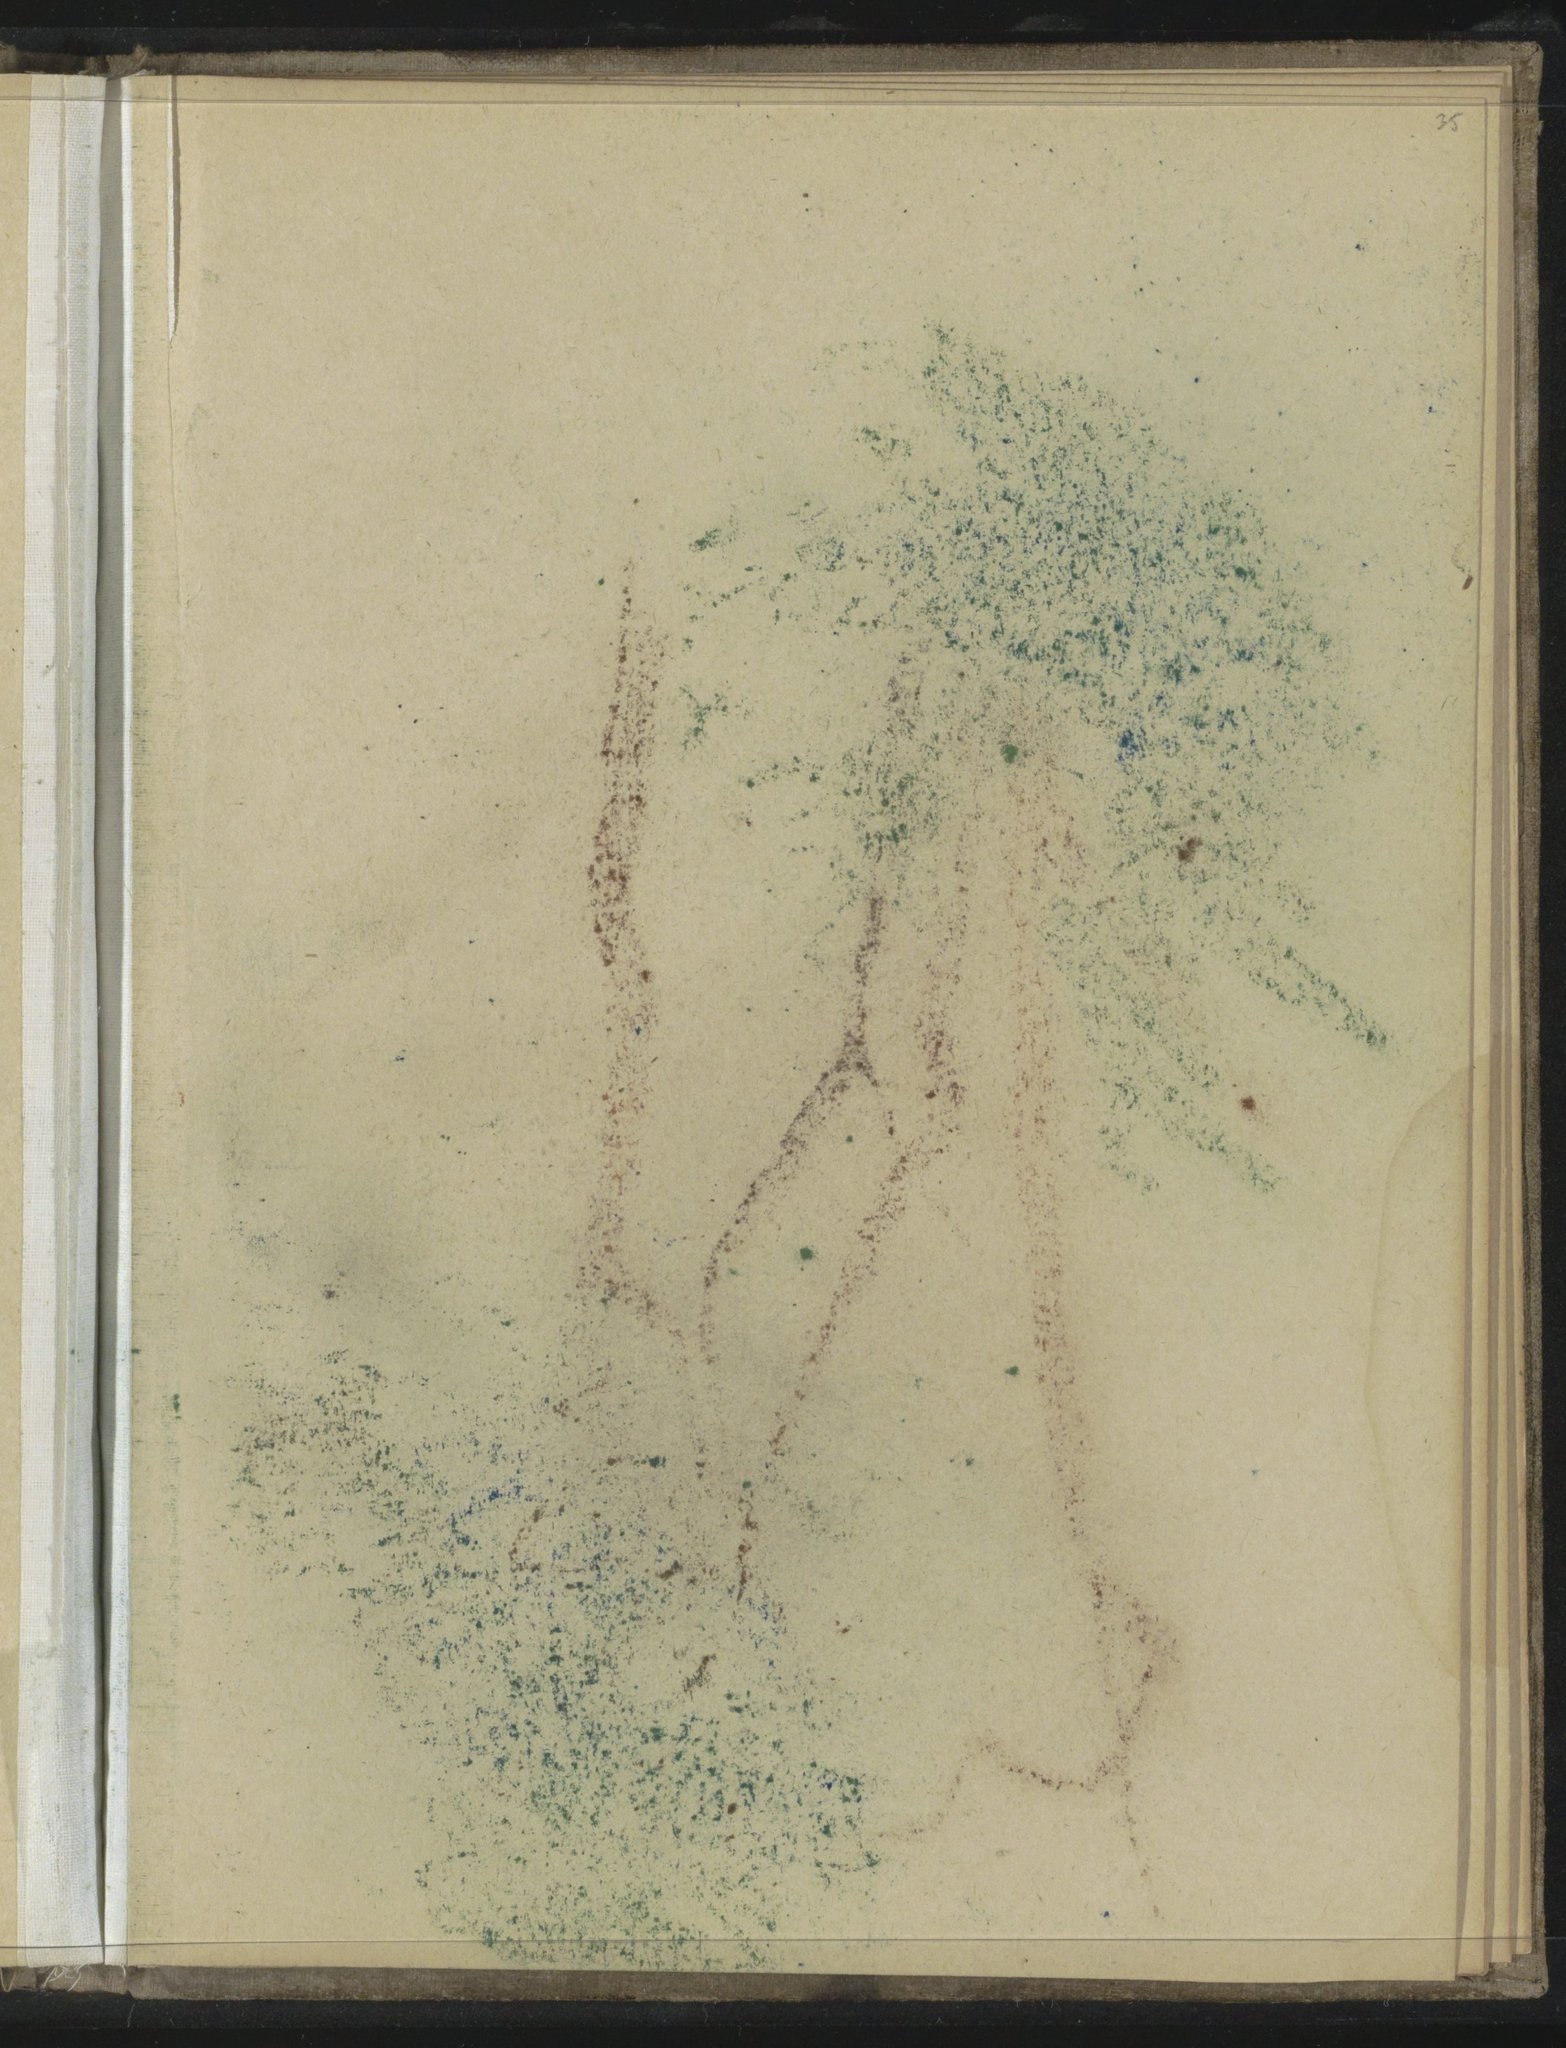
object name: sketchbook leaf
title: Bomen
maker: willem witsen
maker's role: draughtsman, painter, print maker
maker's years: 1860-1923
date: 1892-1897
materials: chalk, paper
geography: north brabant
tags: trees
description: Pagina 35 uit een schetsboek met 24 bladen.